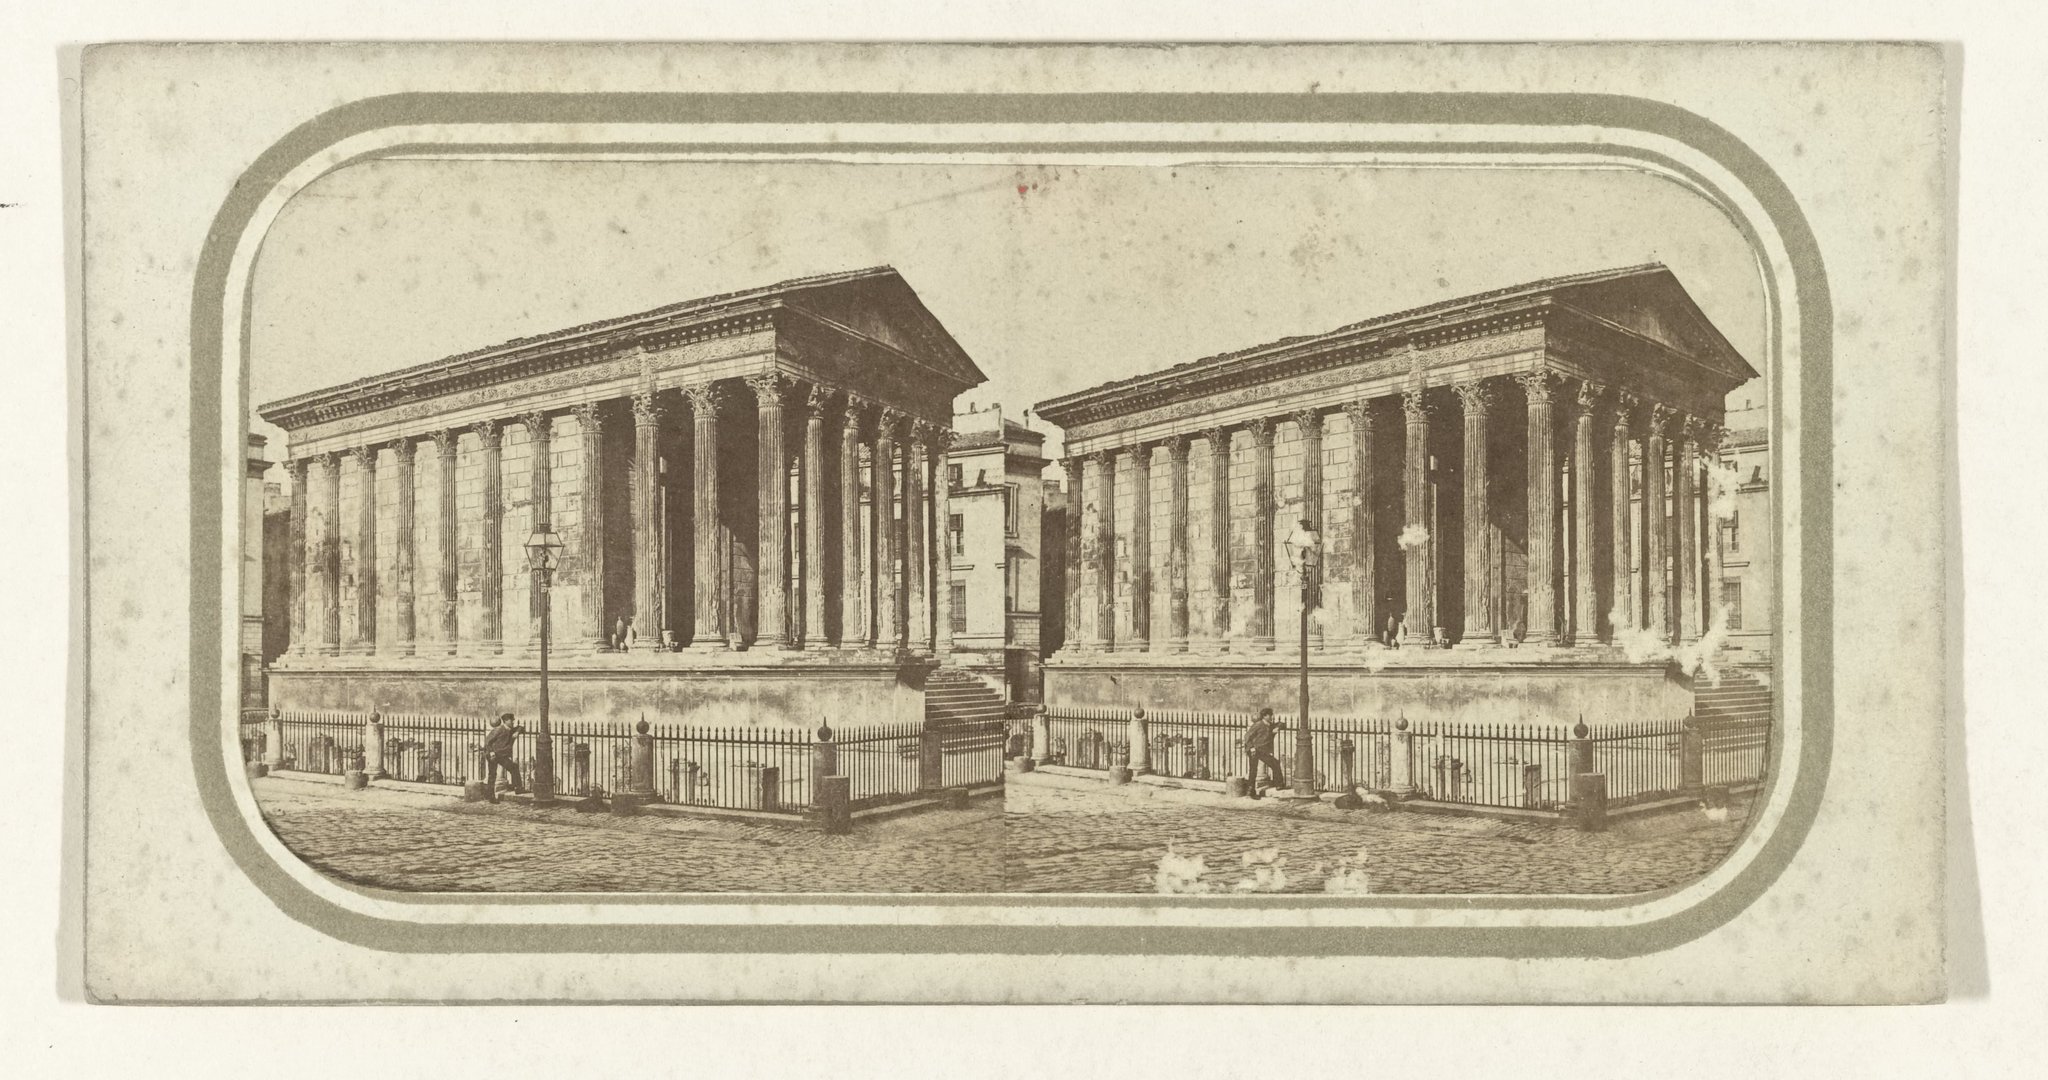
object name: photograph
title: Gezicht op het Maison Carrée in Nîmes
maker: Anonymous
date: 1855-1860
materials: cardboard, paper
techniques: salted paper print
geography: nîmes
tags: temple, shrine ~ roman religion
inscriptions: title: ‘La Maison Carrée Nîmes’